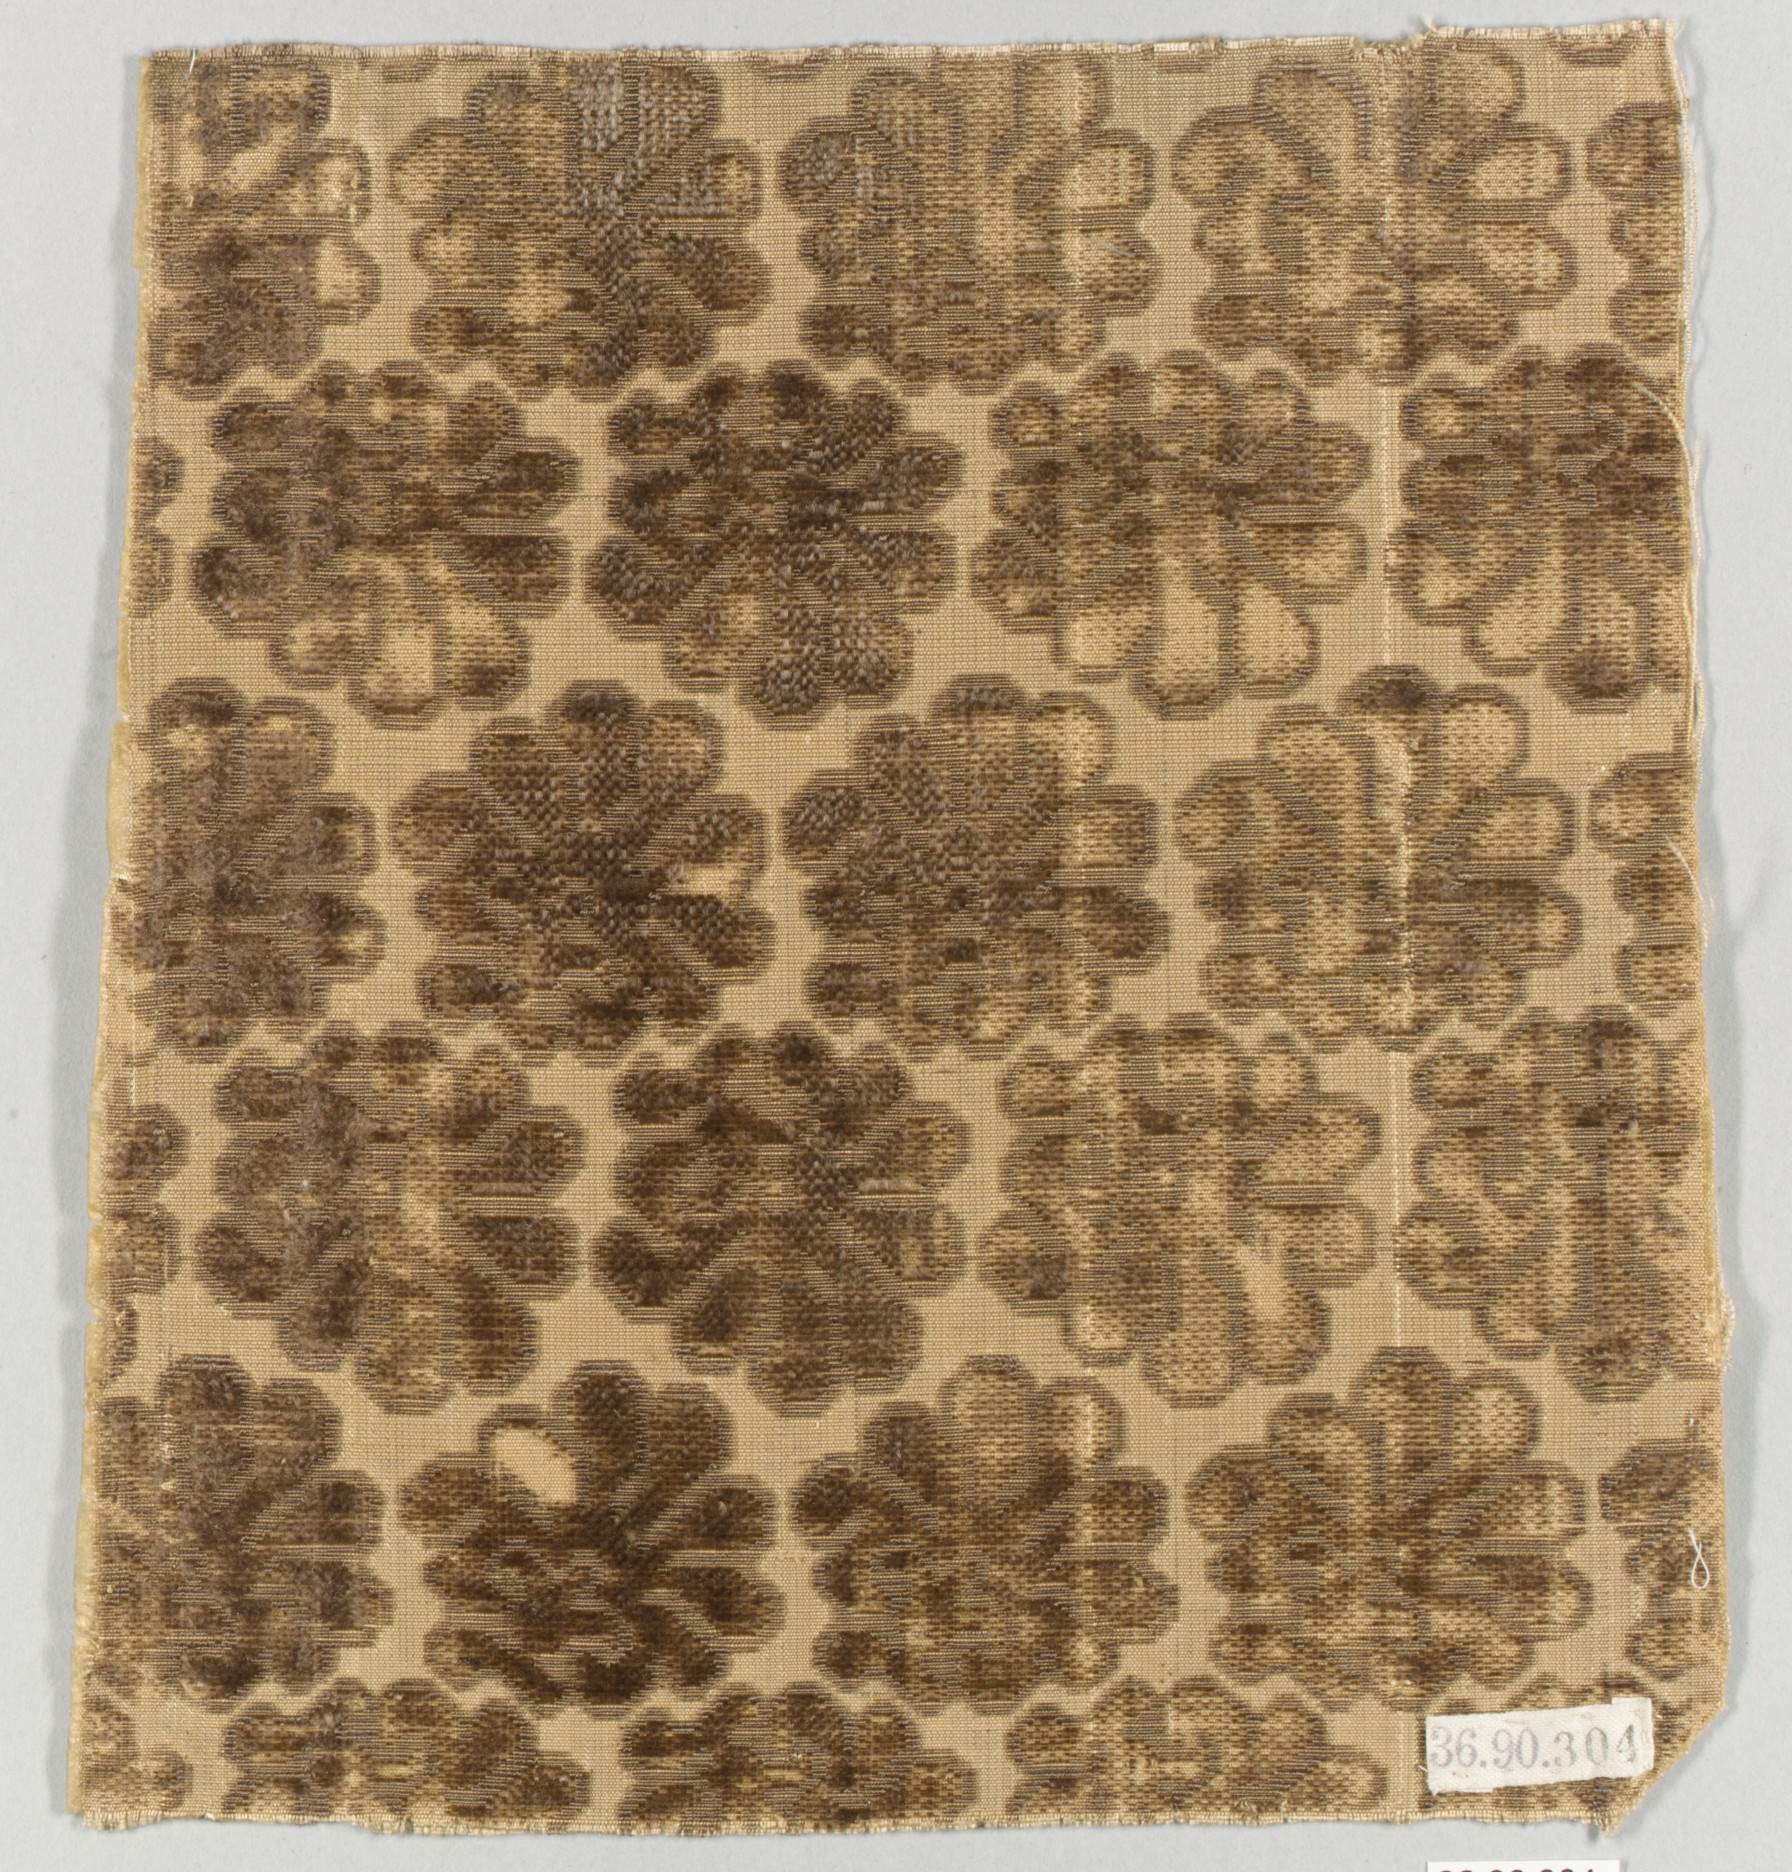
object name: piece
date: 1501-1700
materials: silk